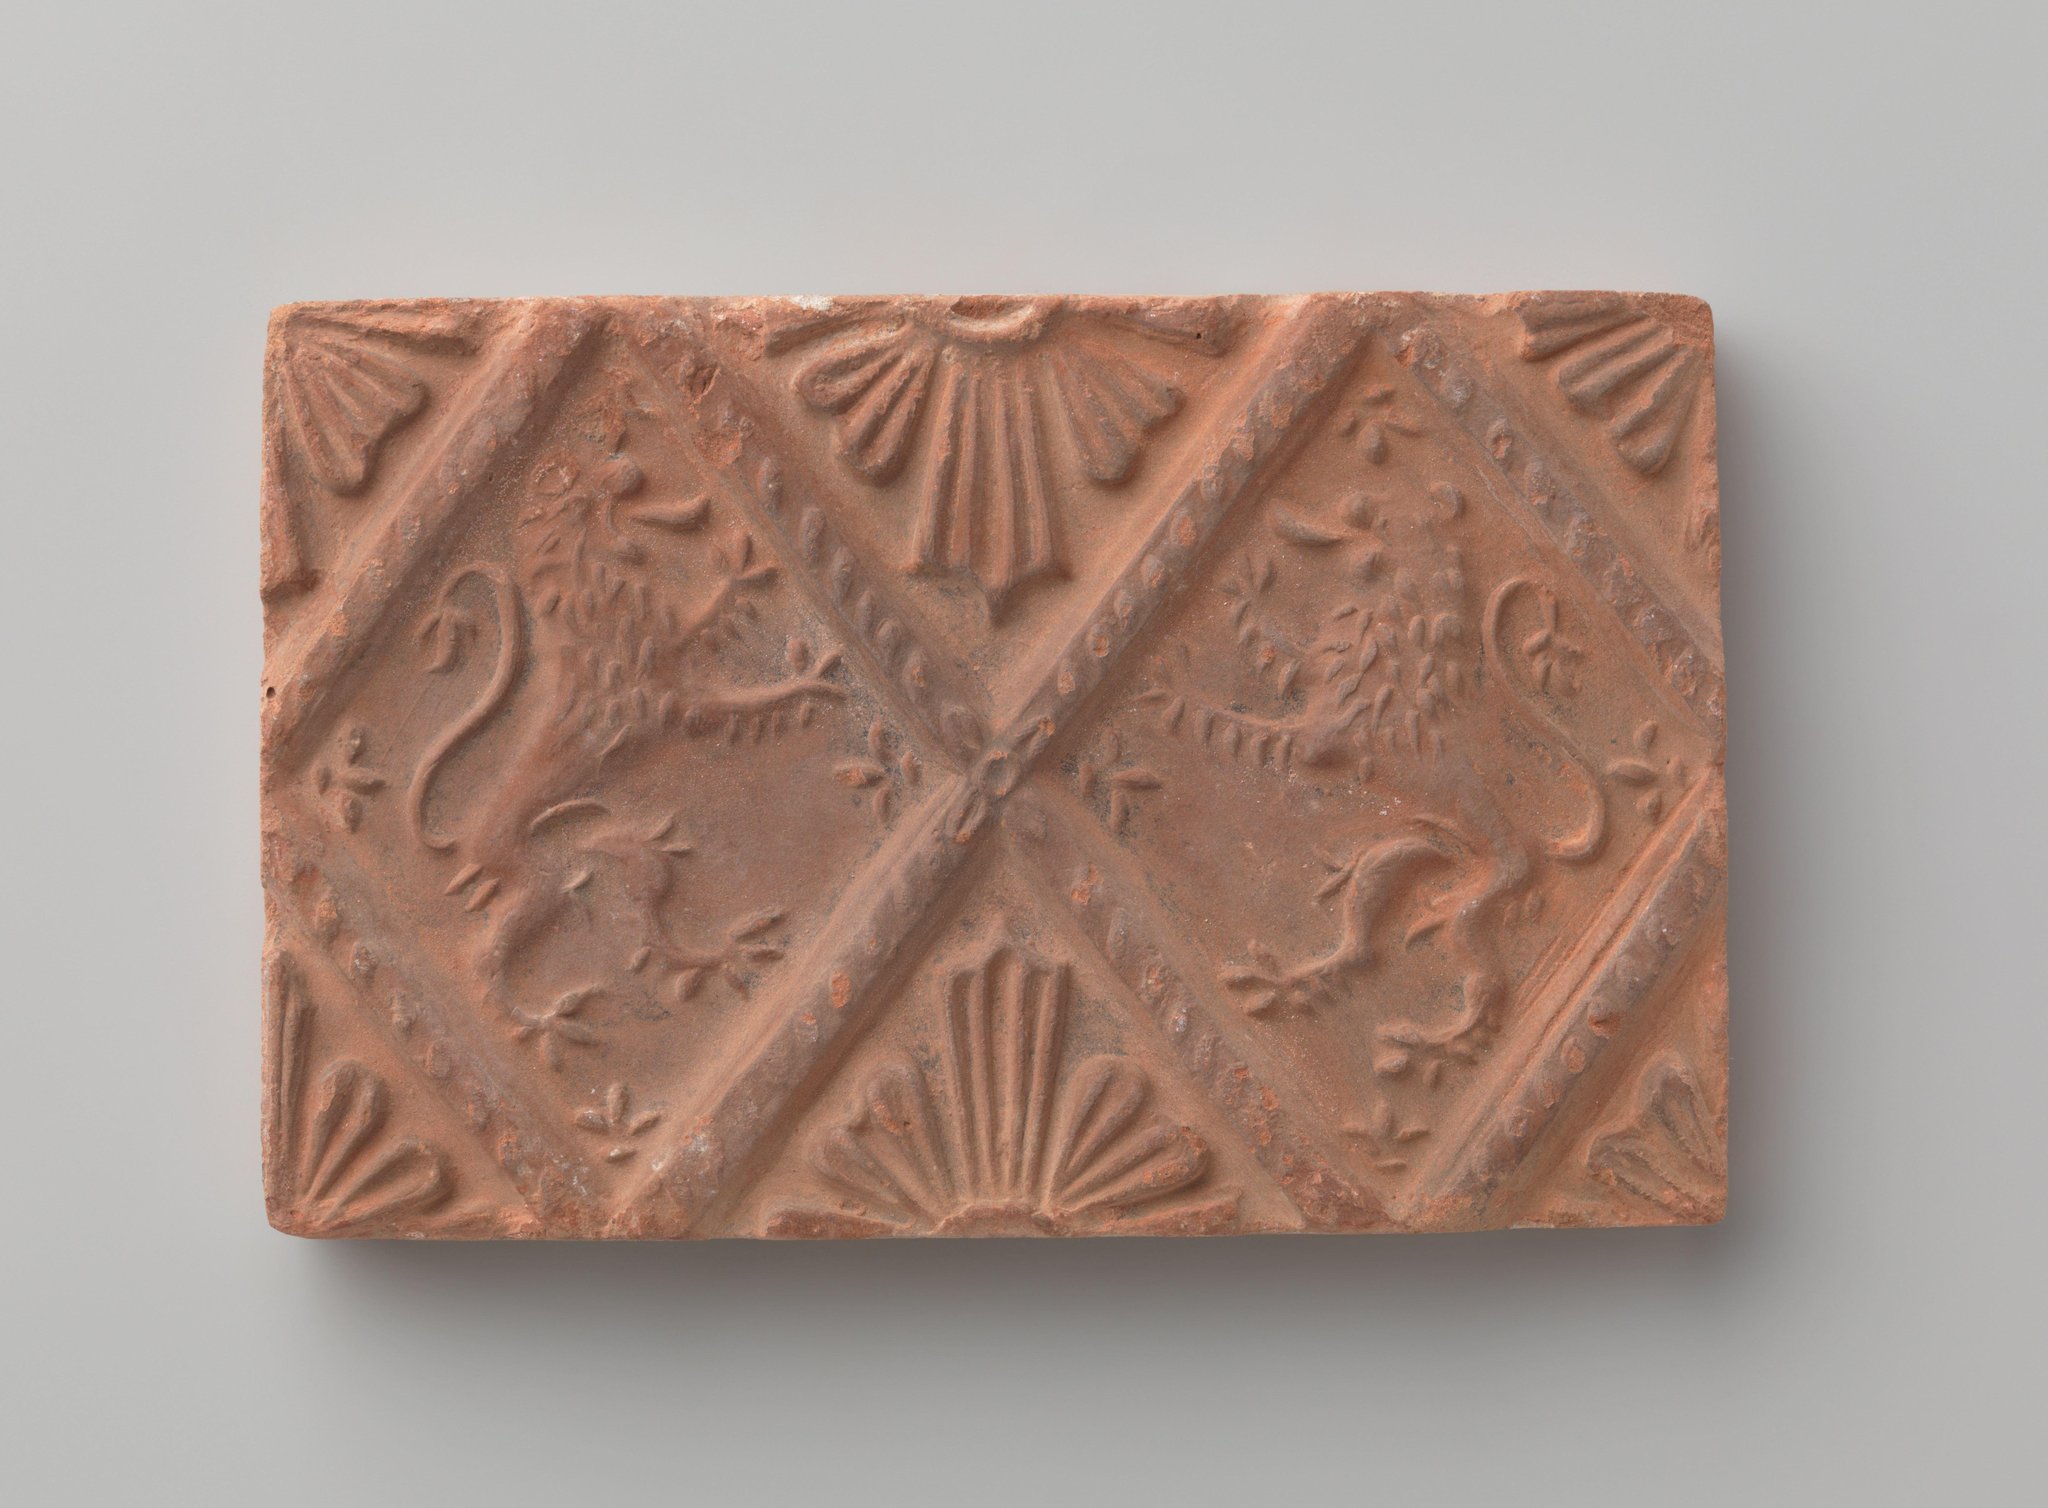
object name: hearthstone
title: Haardsteen met voorstelling van twee klimmende leeuwen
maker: Anonymous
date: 1875-1900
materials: earthenware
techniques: printing, firing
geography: netherlands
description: Haardsteen met voorstelling van twee klimmende leeuwen, geplaatst in geprofileerde ruit. De halve ruiten aan de boven- en onderkant zijn opgevuld met stermotief.